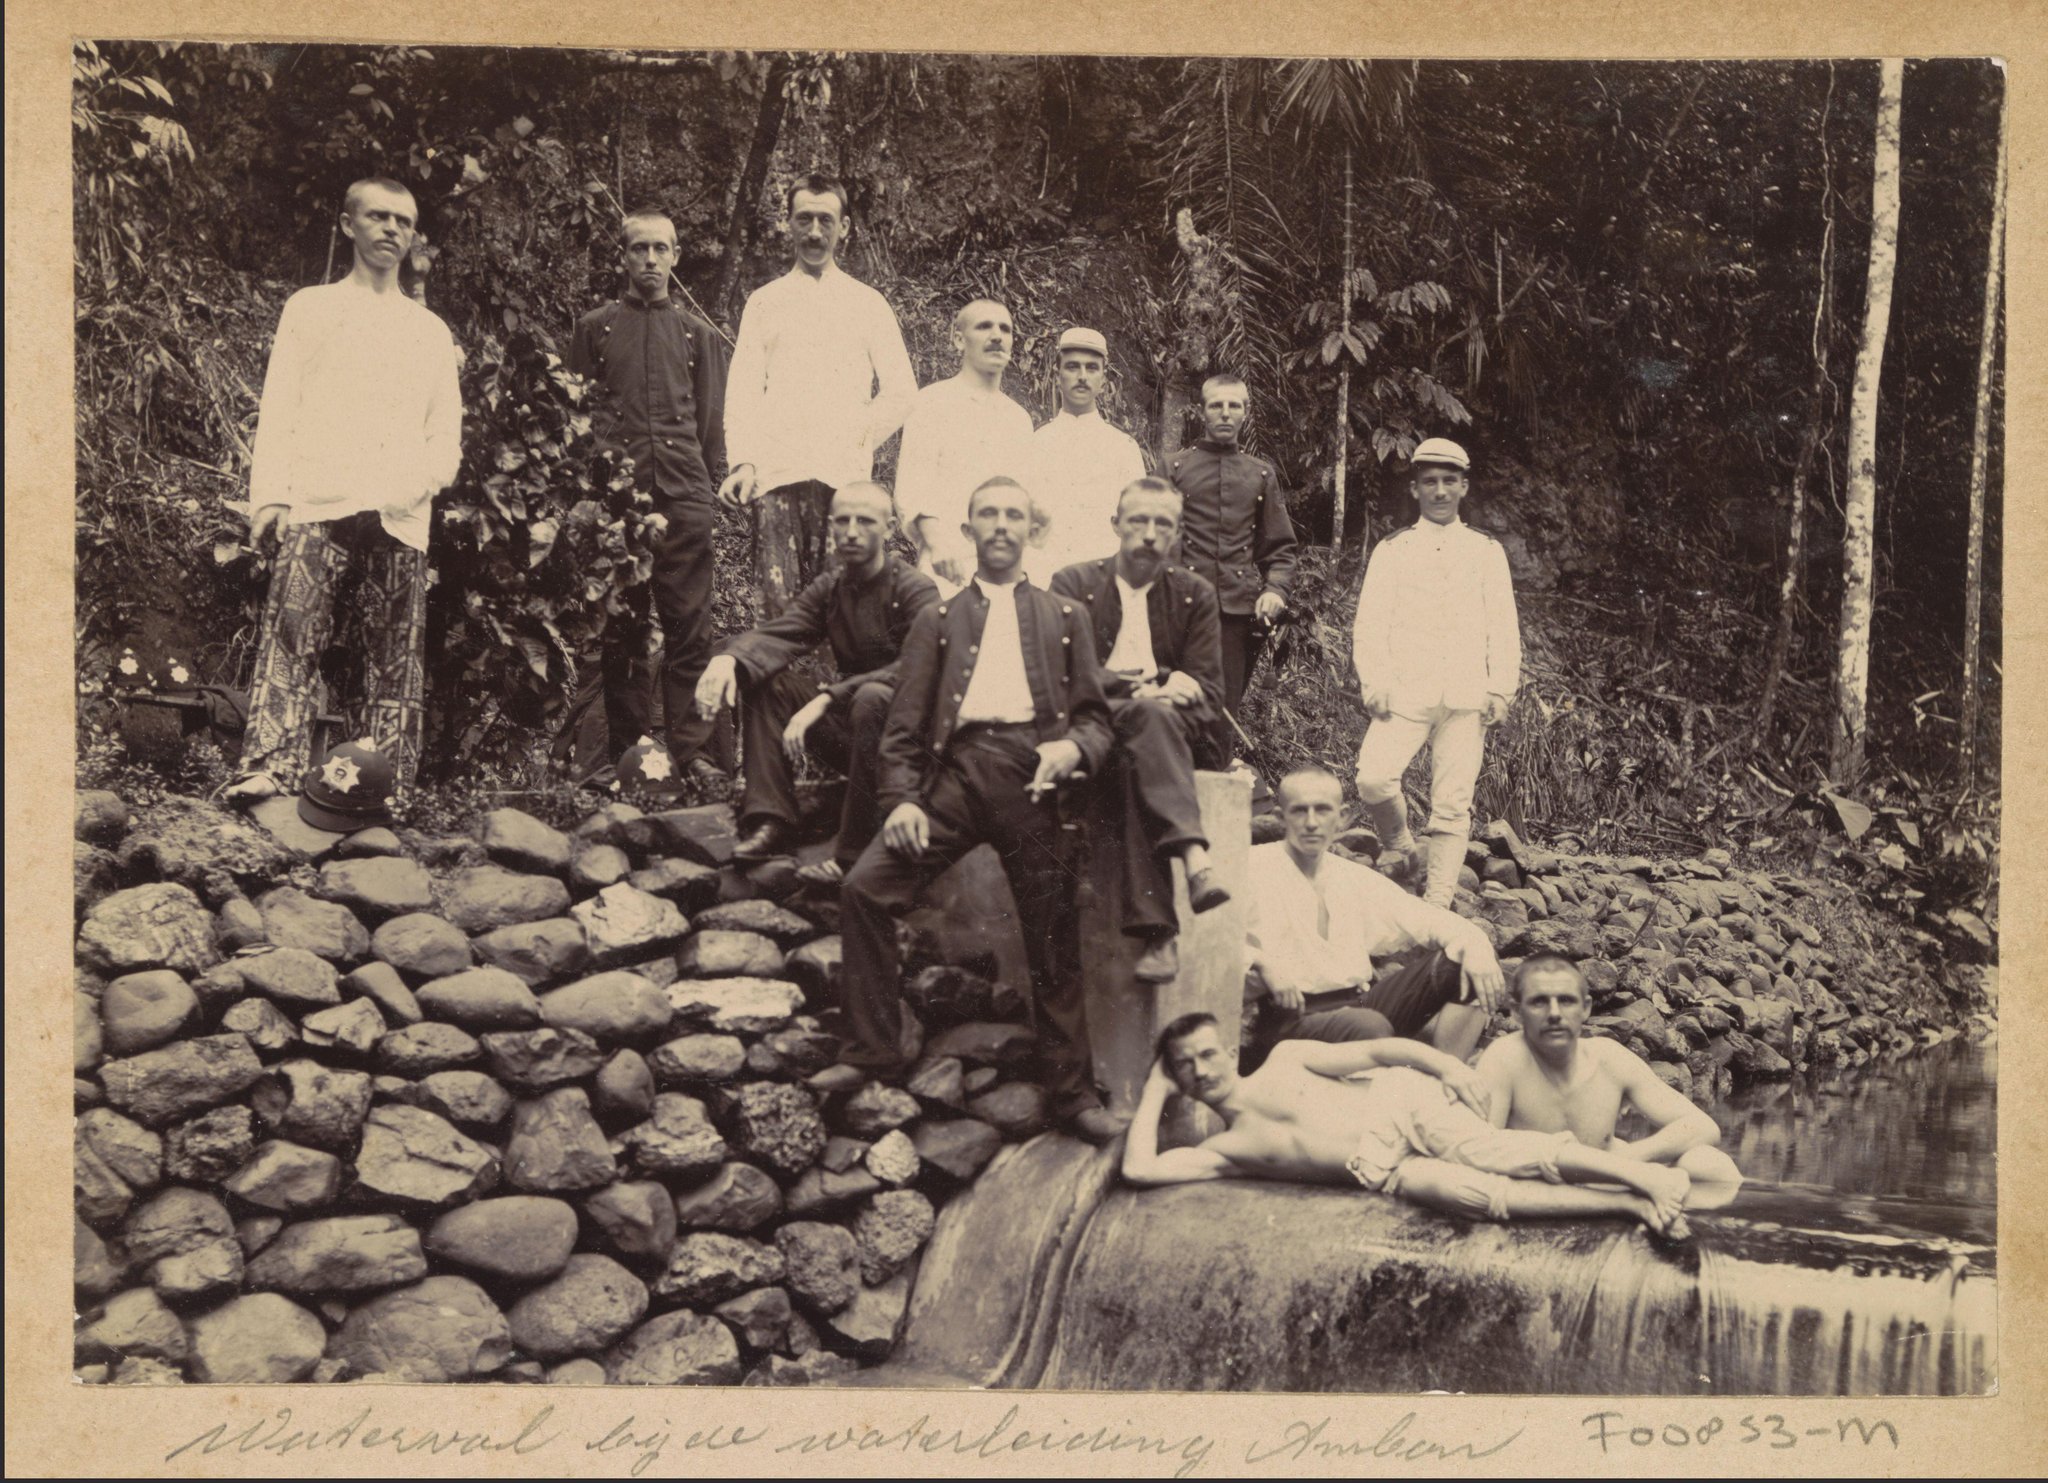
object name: album leaf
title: Waterval bij de waterleiding Ambon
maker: Anonymous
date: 1900-1920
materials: cardboard, paper, photographic support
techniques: gelatin silver print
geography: ambon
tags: water-supply (~ public services), dutch east indies, the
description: Onderdeel van Reisalbum met foto's van Ambon.